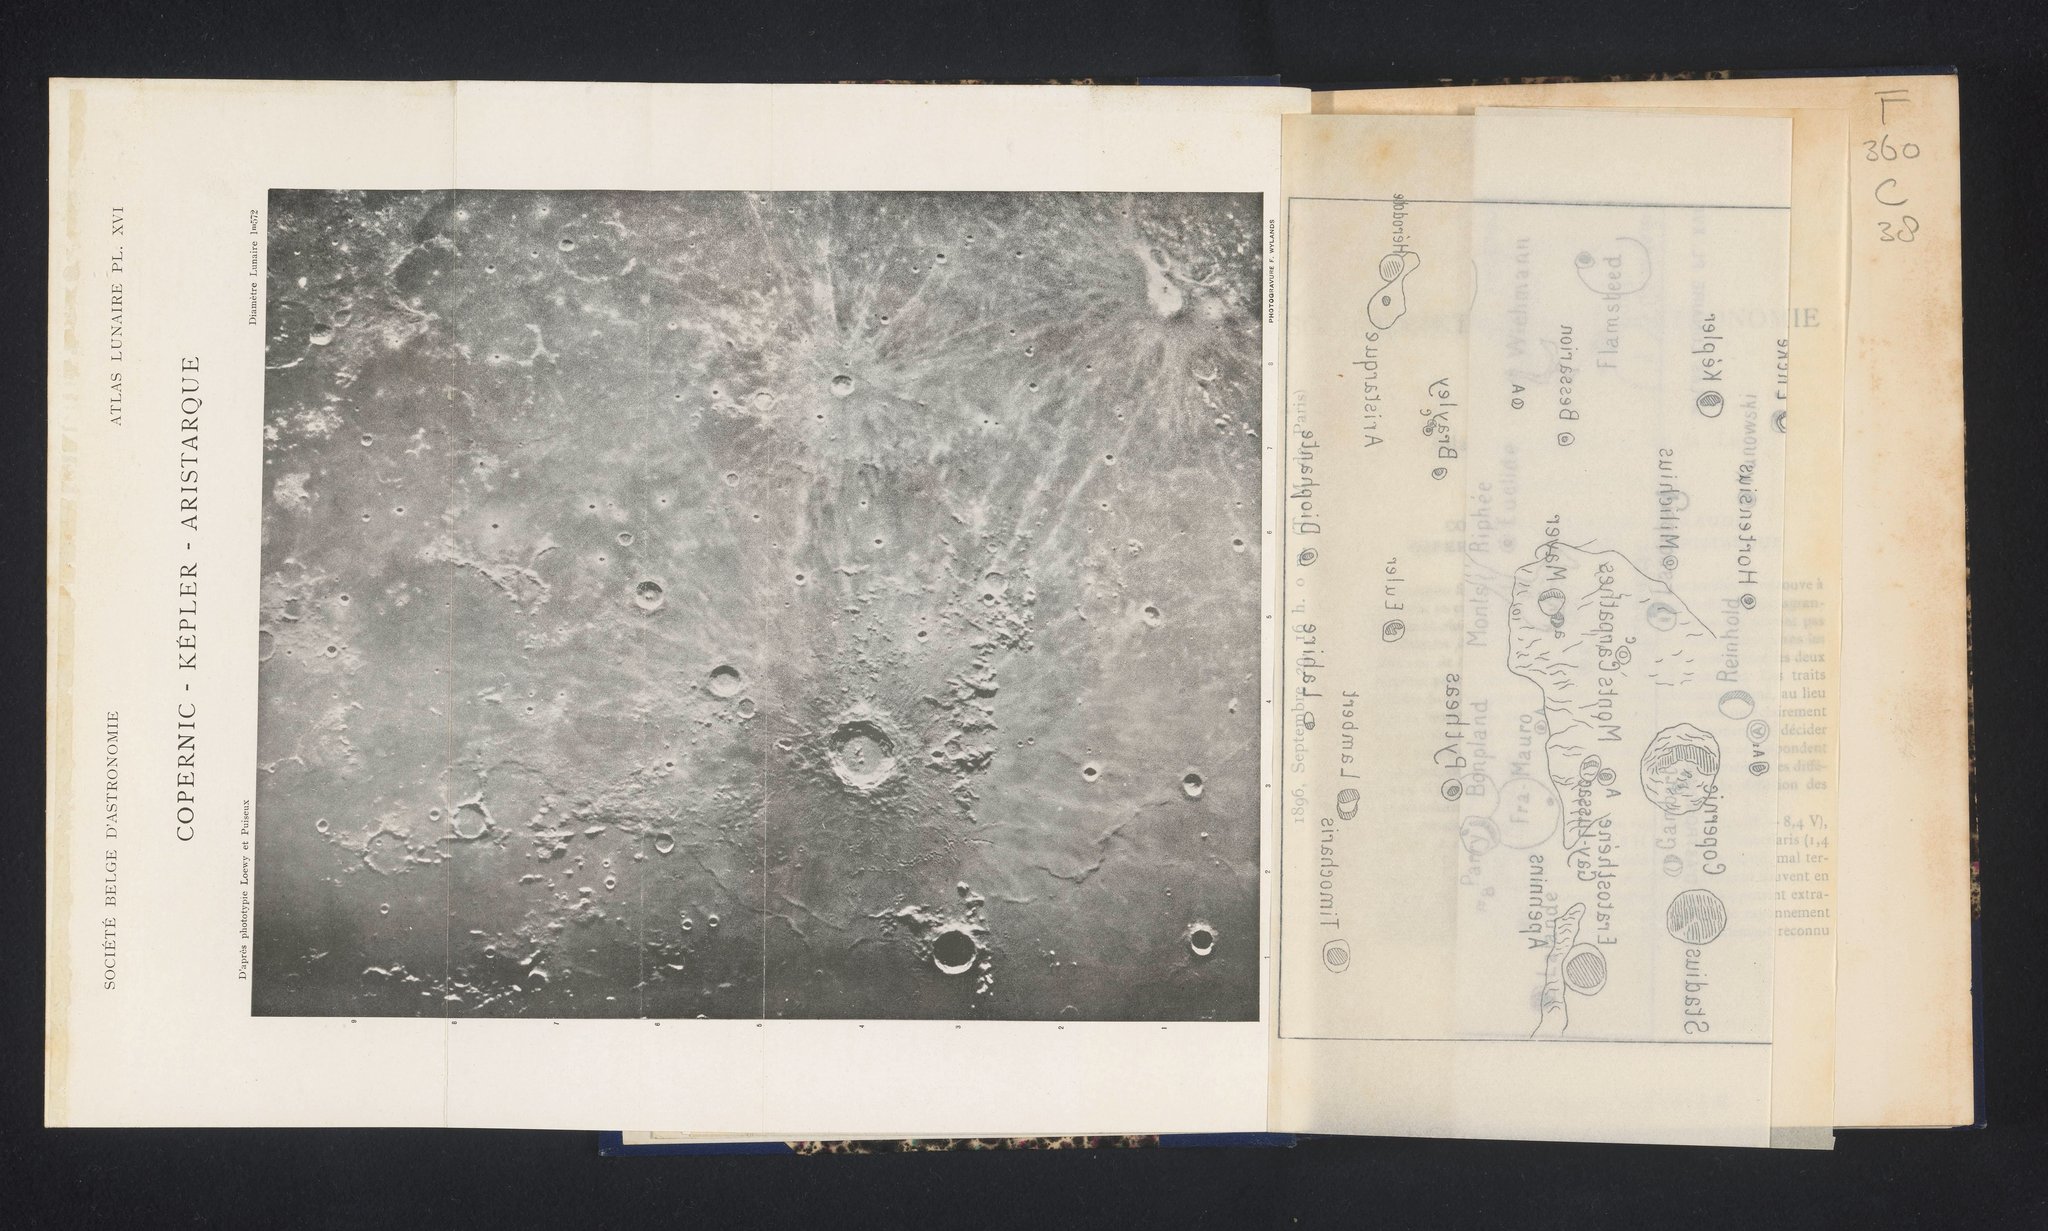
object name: page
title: Copernic - Képler- Aristarque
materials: paper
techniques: autotype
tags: surface of the moon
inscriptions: inscription: ‘Société Belge D'Astronomie Atlas Lunaire Pl. XVI/ 1896, Septembre 29, 16 h. 0m. (T. M. de Paris)’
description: Transparante pagina voor prent als kaart met daarop de namen van de verschillende kraters.